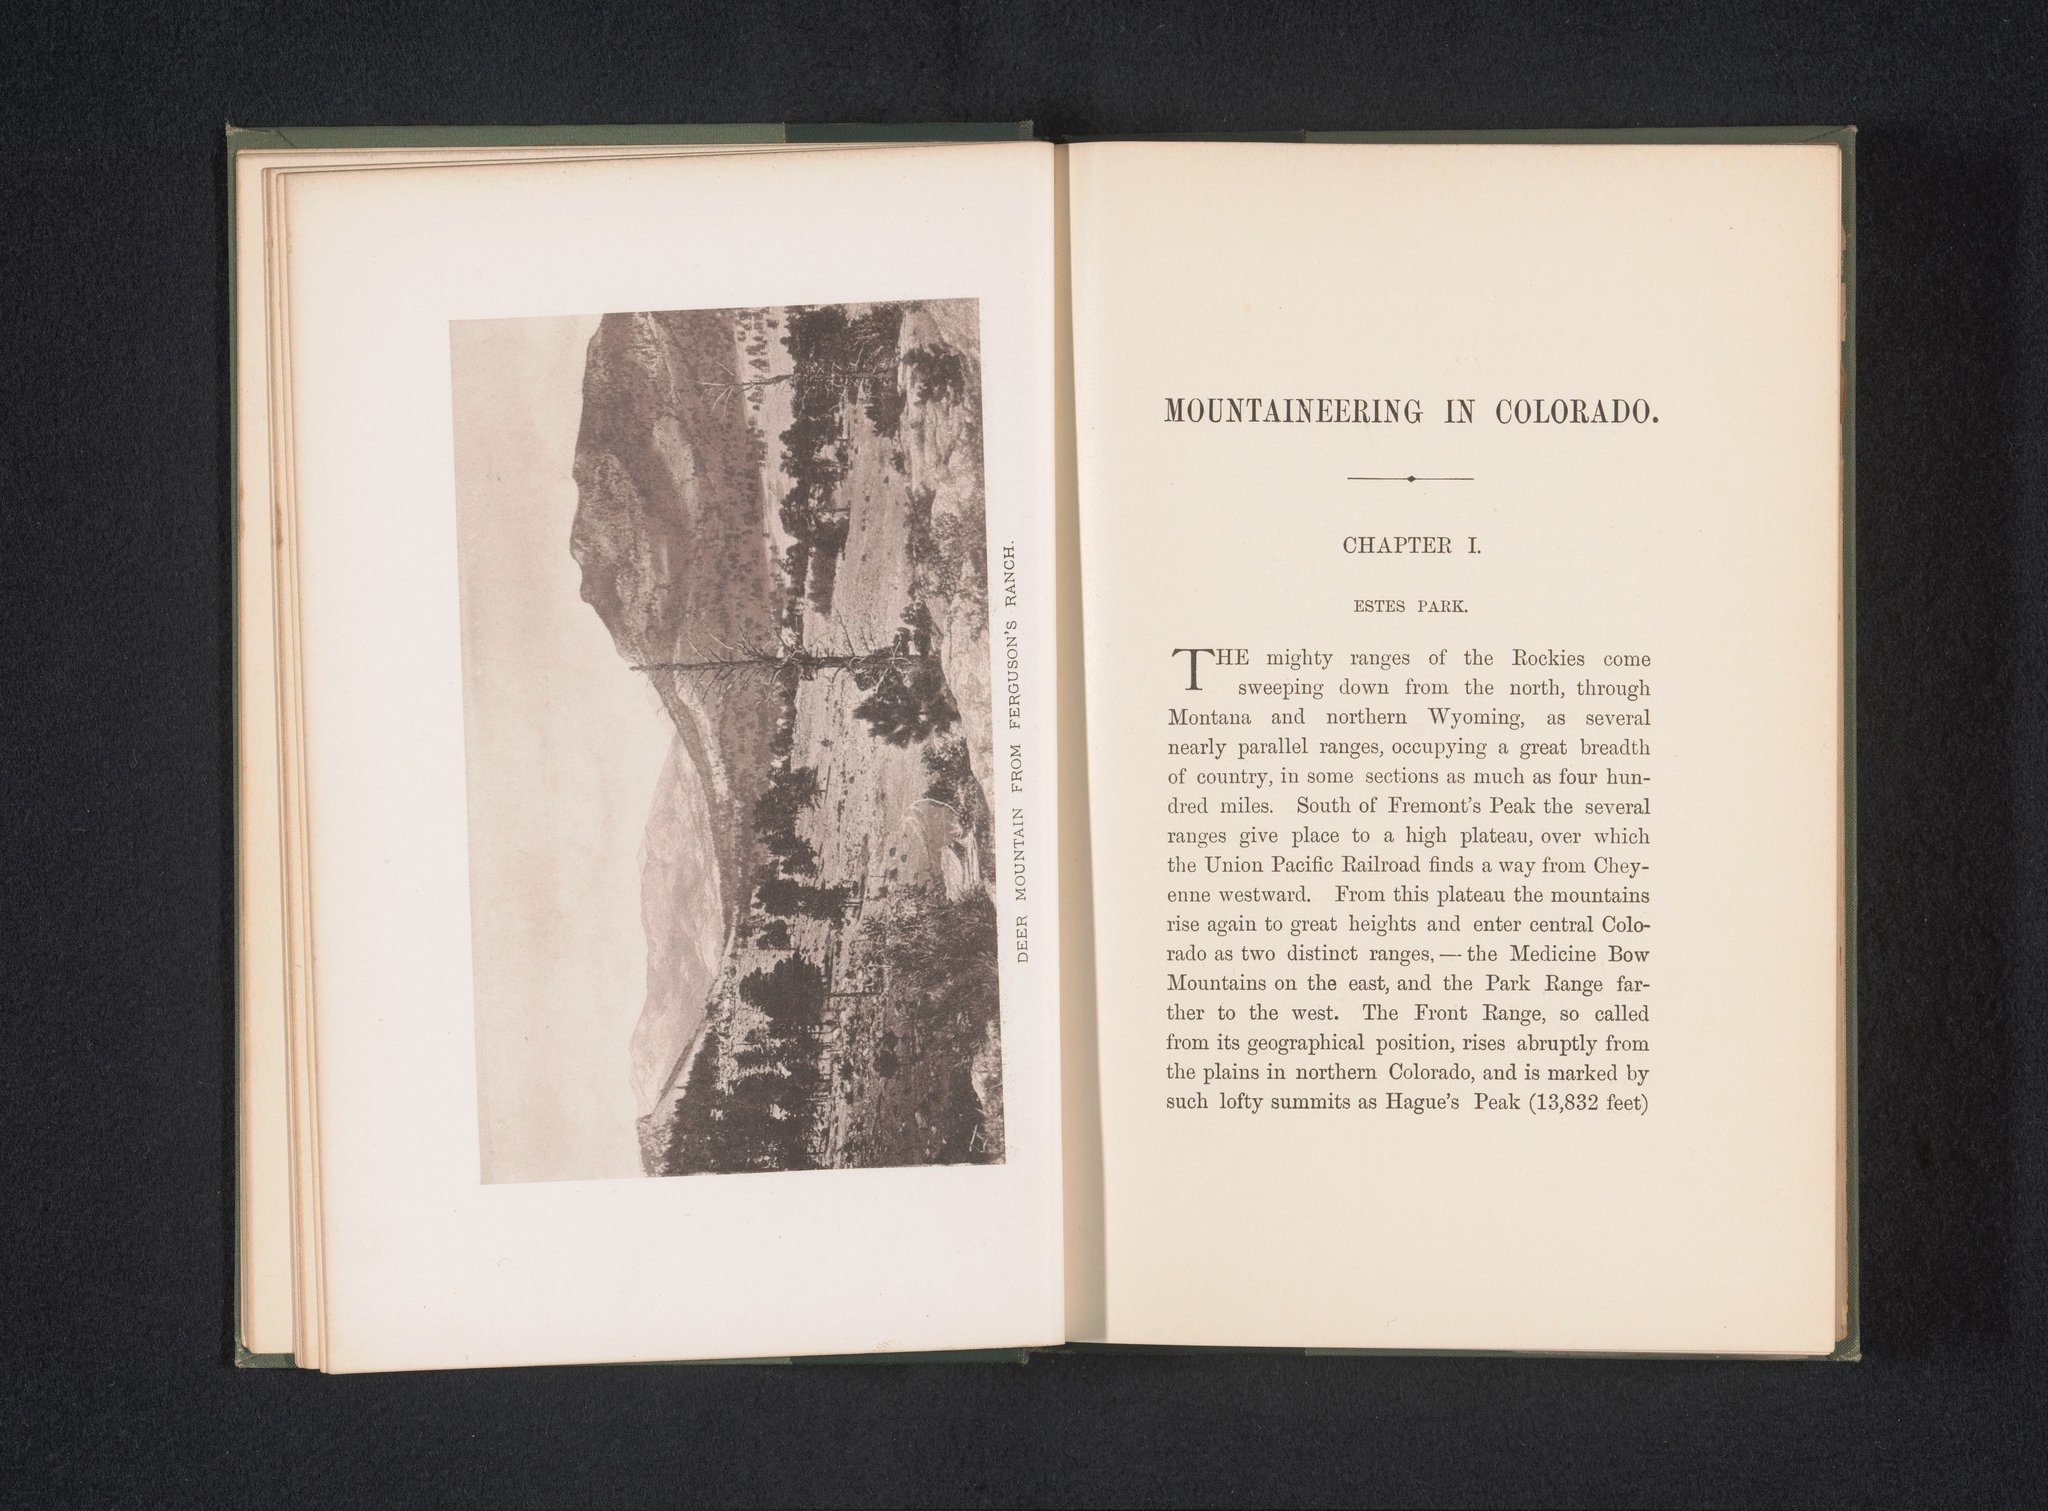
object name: page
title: Gezicht op Deer Mountain in het Rocky Mountain National Park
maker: frederick hastings chapin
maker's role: antropoloog, archeoloog, fotograaf, schrijver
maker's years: 1852-1900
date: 1885-1890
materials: paper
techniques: photograph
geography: rocky mountain national park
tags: landscapes, wildlife reserve, national park, mountains